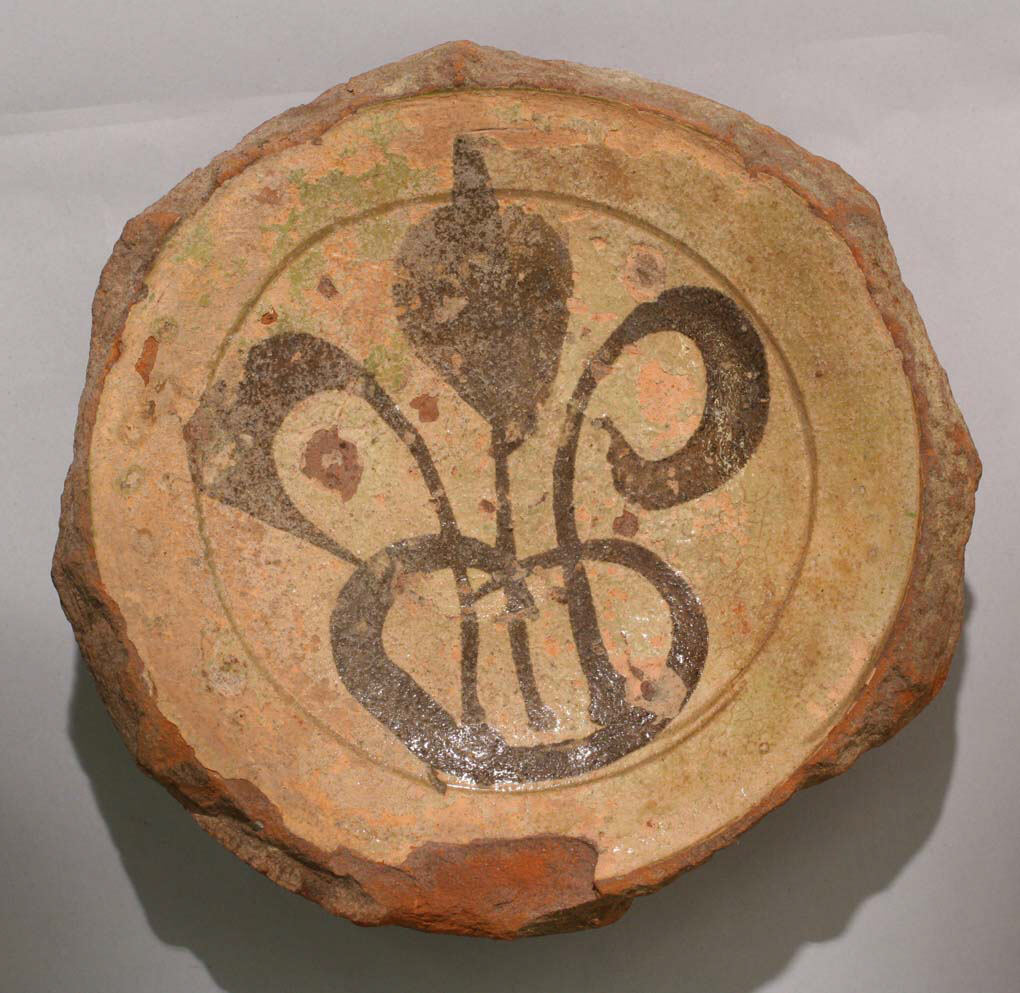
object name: fragment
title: Fragment of a Bowl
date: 1301-1500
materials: earthenware, glaze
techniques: coloring, incising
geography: egypt